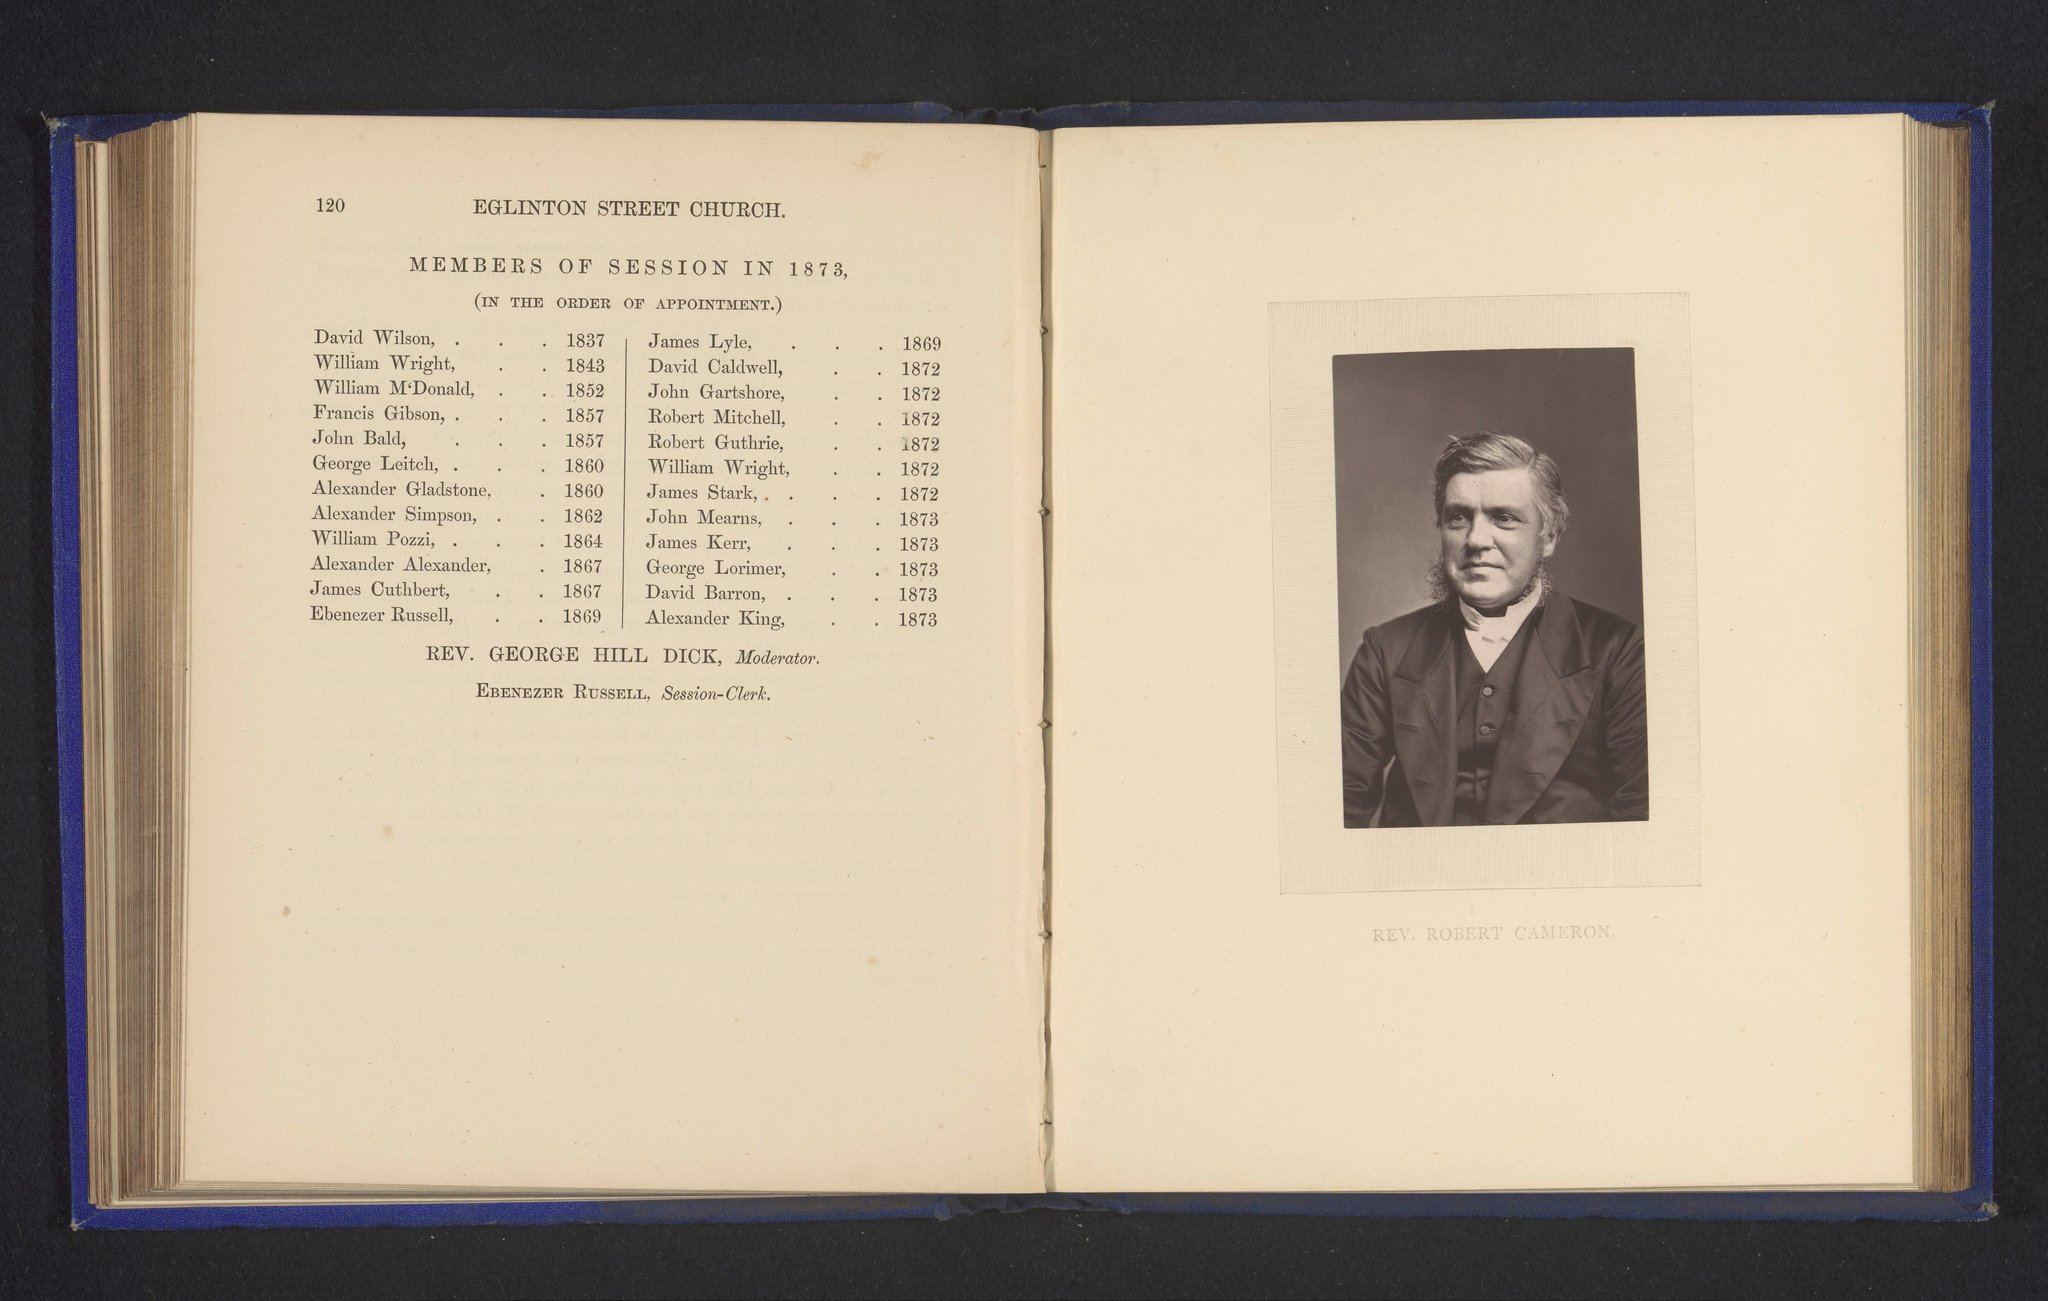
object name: photomechanical print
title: Rev. Robert Cameron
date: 1865-1875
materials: paper, photographic support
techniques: carbon print, woodburytype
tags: functionaries and dignitaries (with name) ~ protestant churches